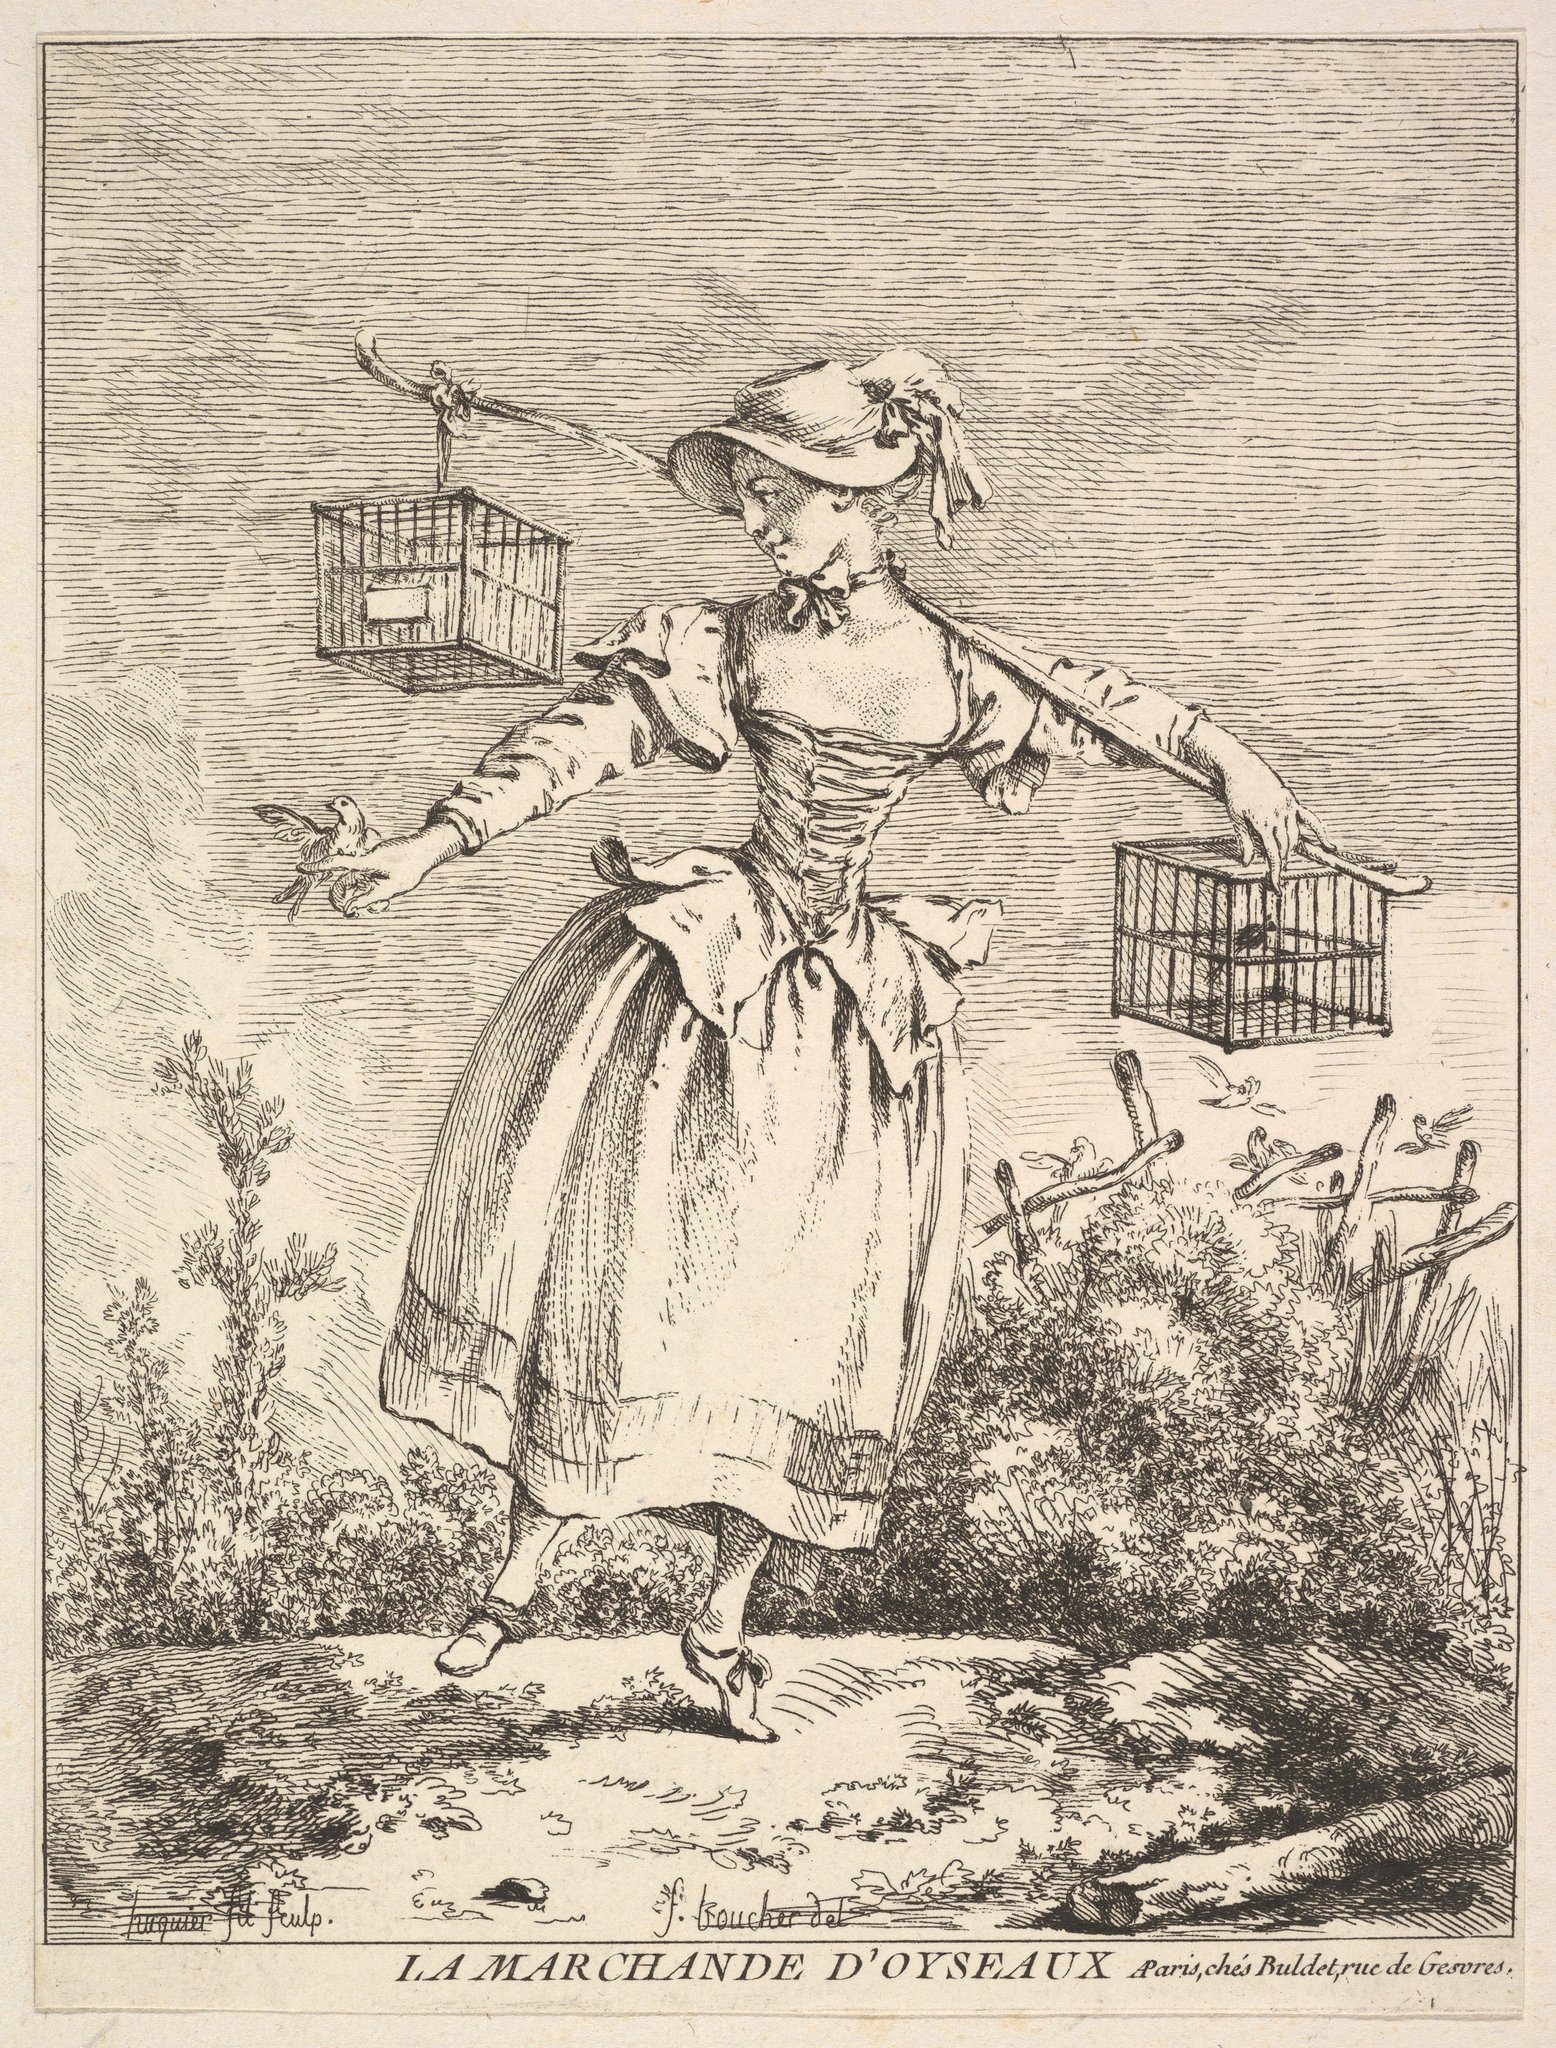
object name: print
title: La marchande d'oyseaux (The Bird Merchant)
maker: jacques gabriel huquier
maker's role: artist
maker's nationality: french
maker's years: 1730-1805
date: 1701-1800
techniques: etching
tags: birds,women,merchants